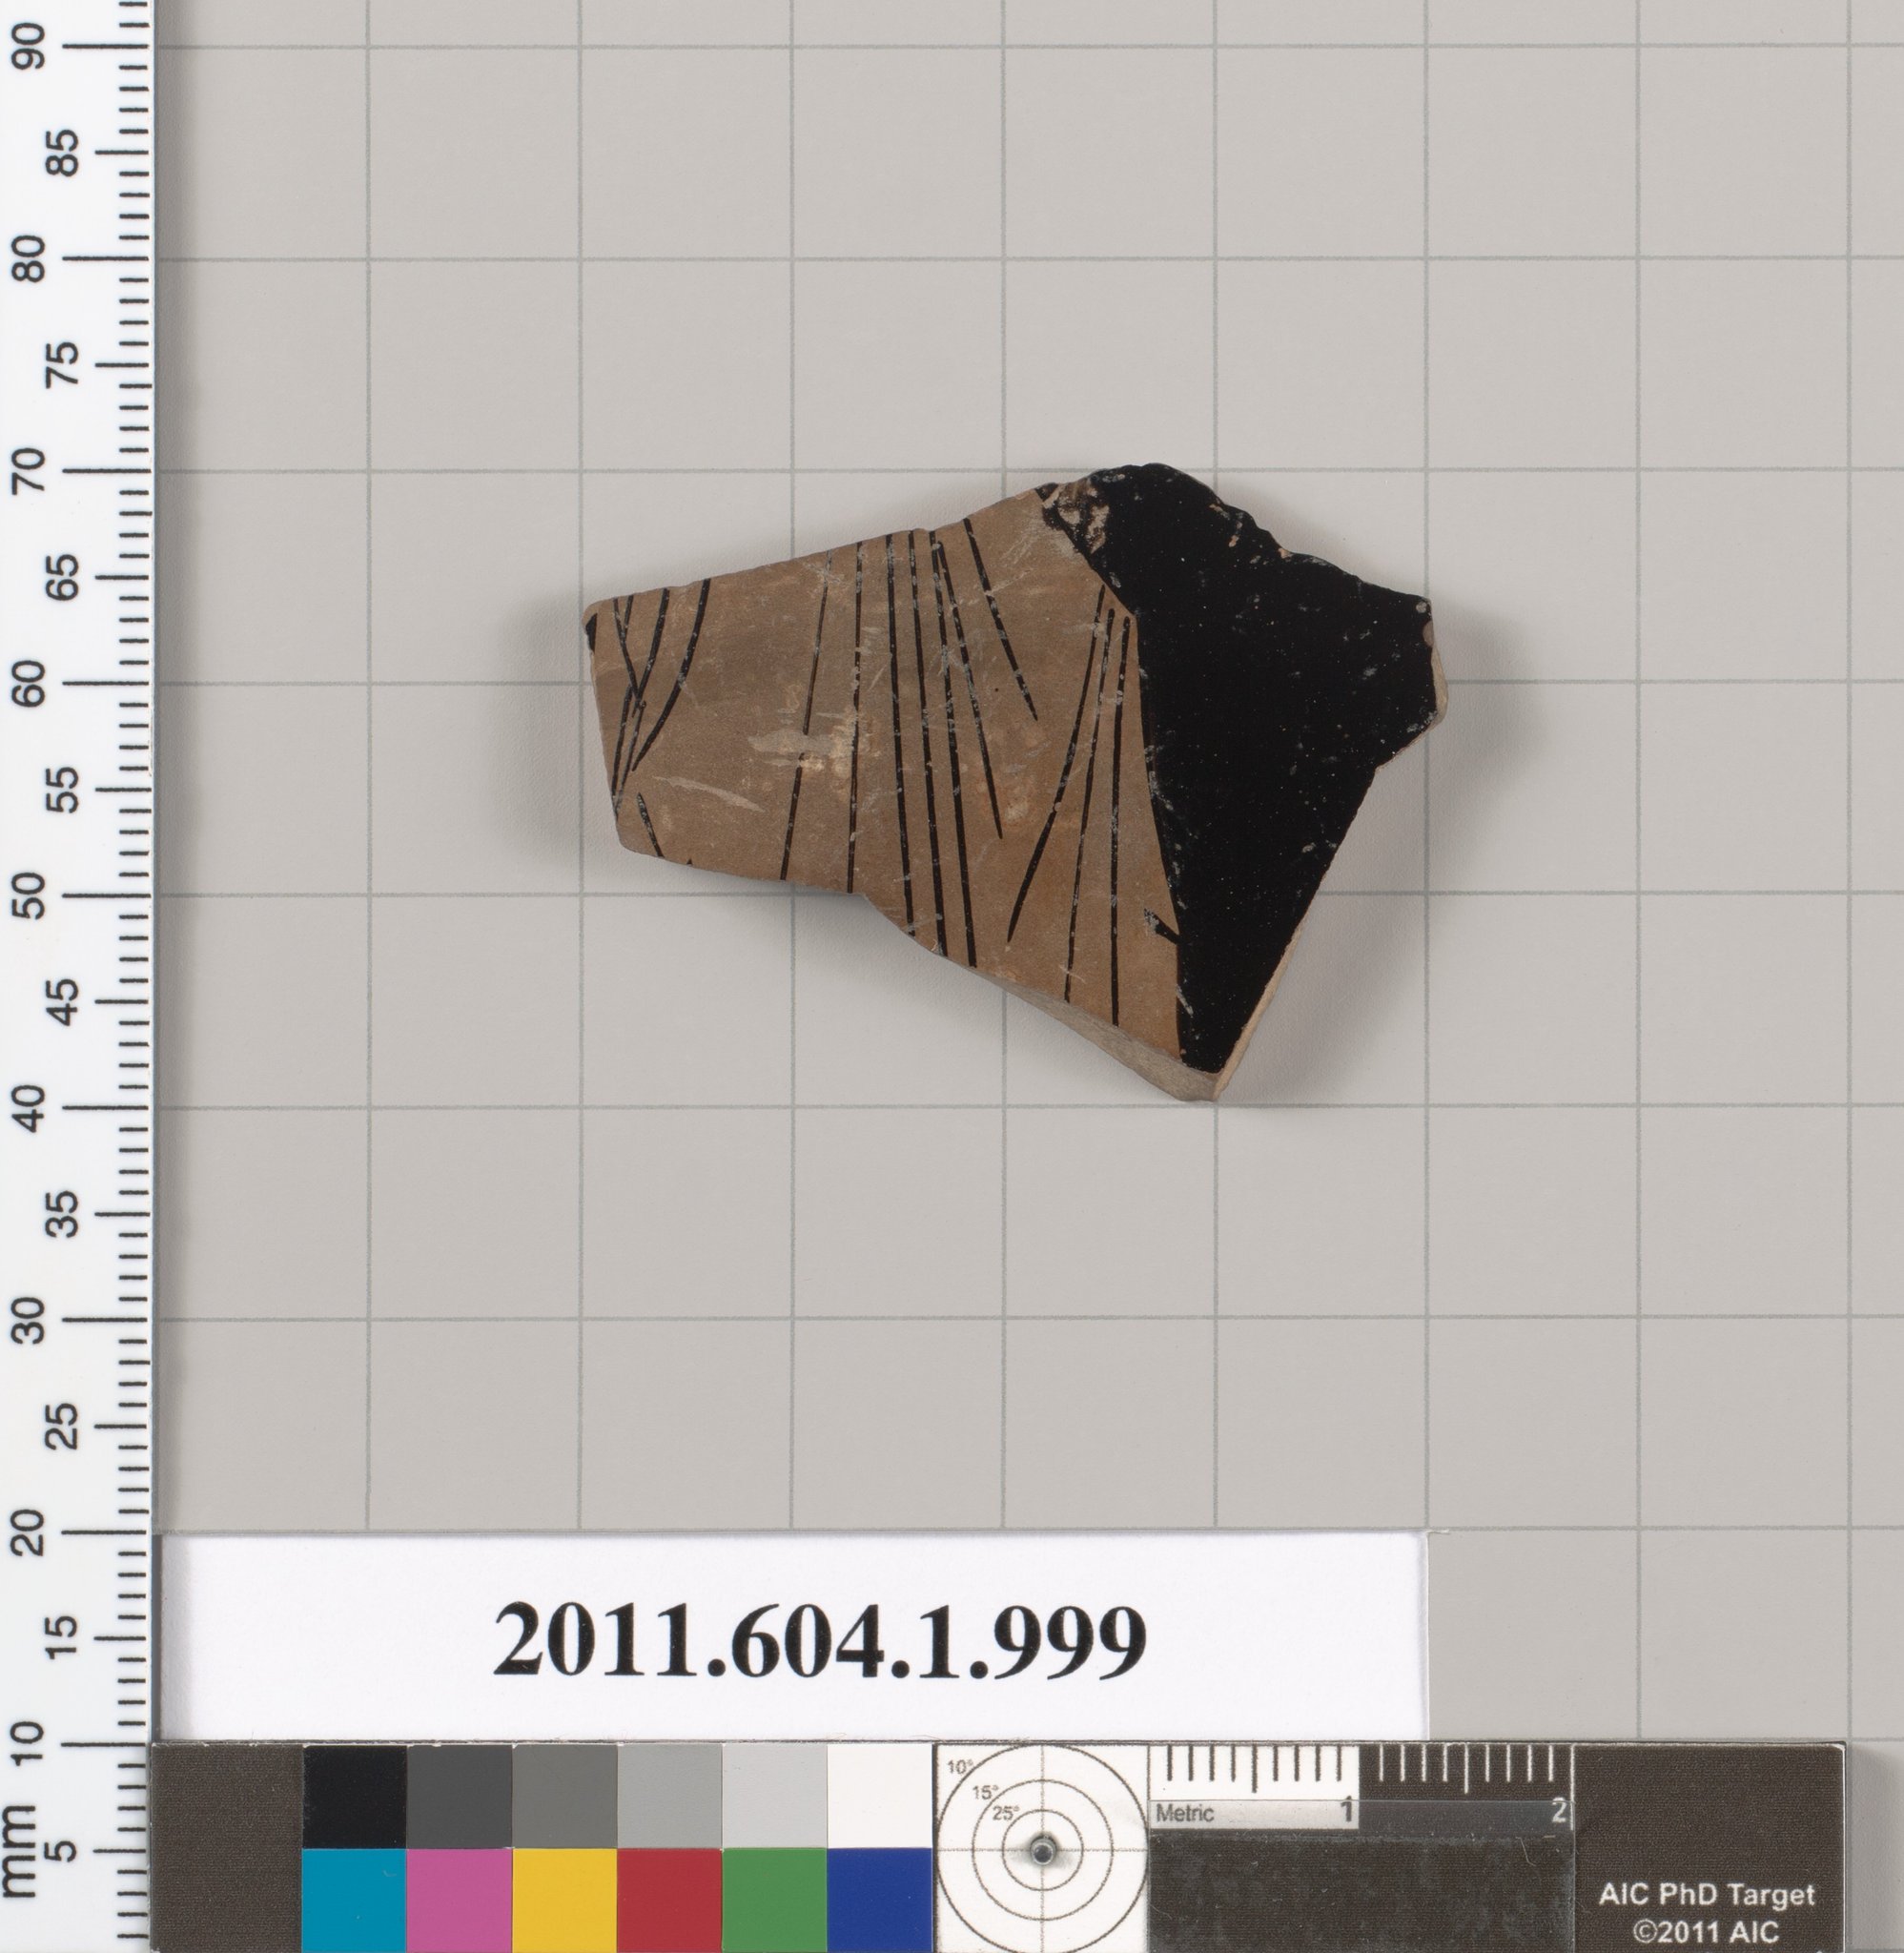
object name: kylix fragment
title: Terracotta fragment of a kylix (drinking cup)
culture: greek, attic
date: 475-451 BCE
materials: terracotta